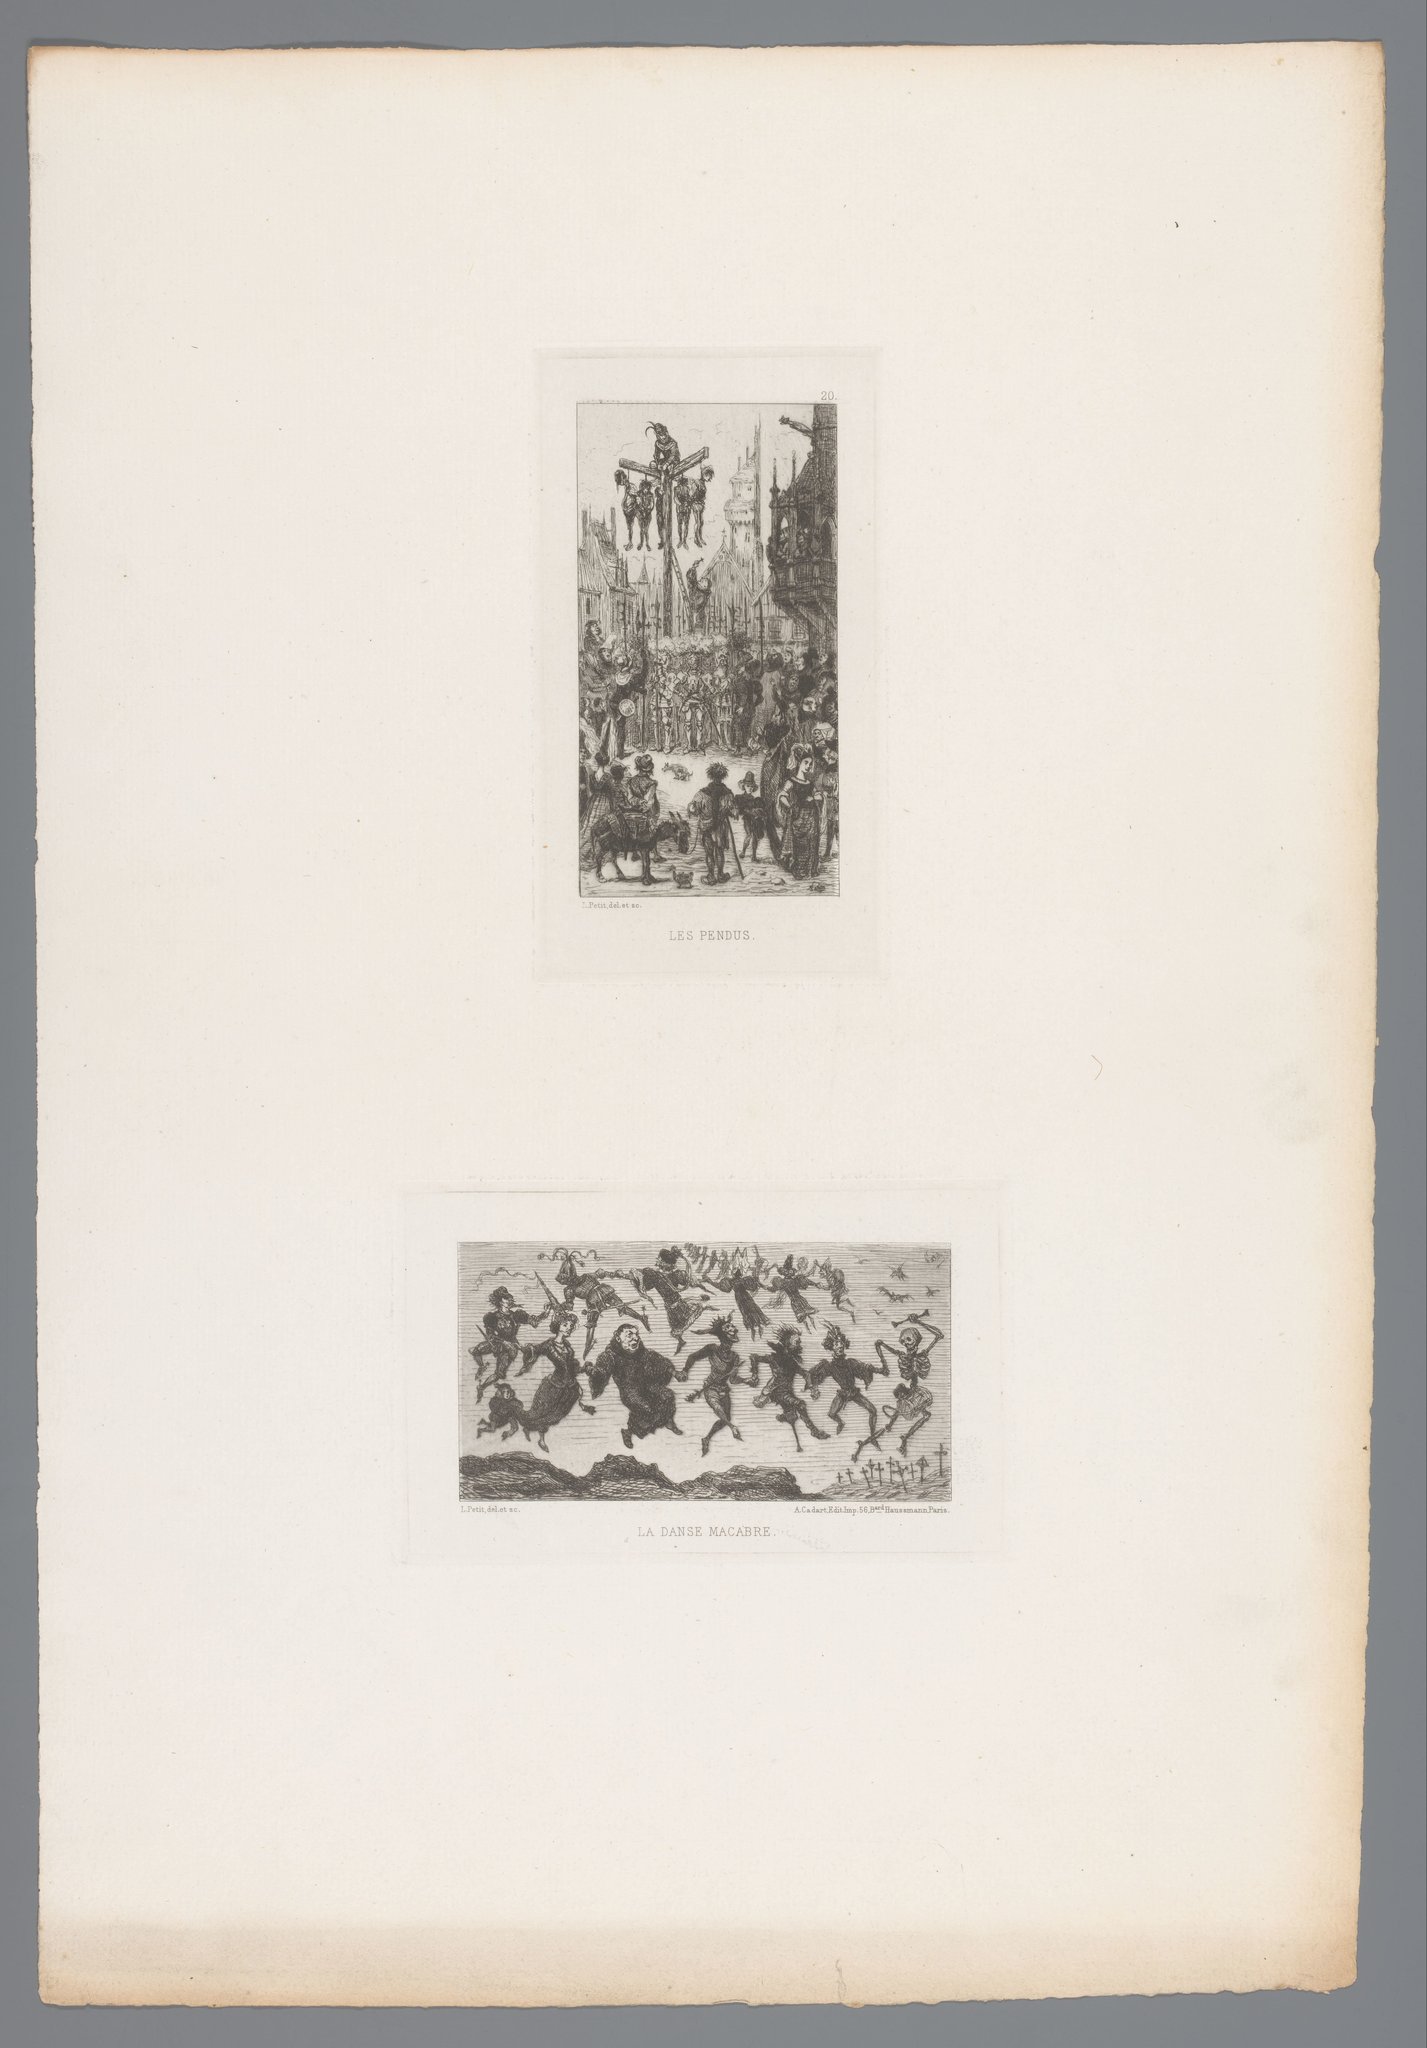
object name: print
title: Franse etsen uit 1875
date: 1875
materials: paper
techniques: drypoint, etching, intaglio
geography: paris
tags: instruments of torture, execution or punishment: gallows, city-view, and landscape with man-made constructions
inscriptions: collector's mark: Lugt 2760, collector's mark: Lugt 2228, collector's mark: ‘AFE v S’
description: Prent op onversneden blad met RP-P-1991-230.